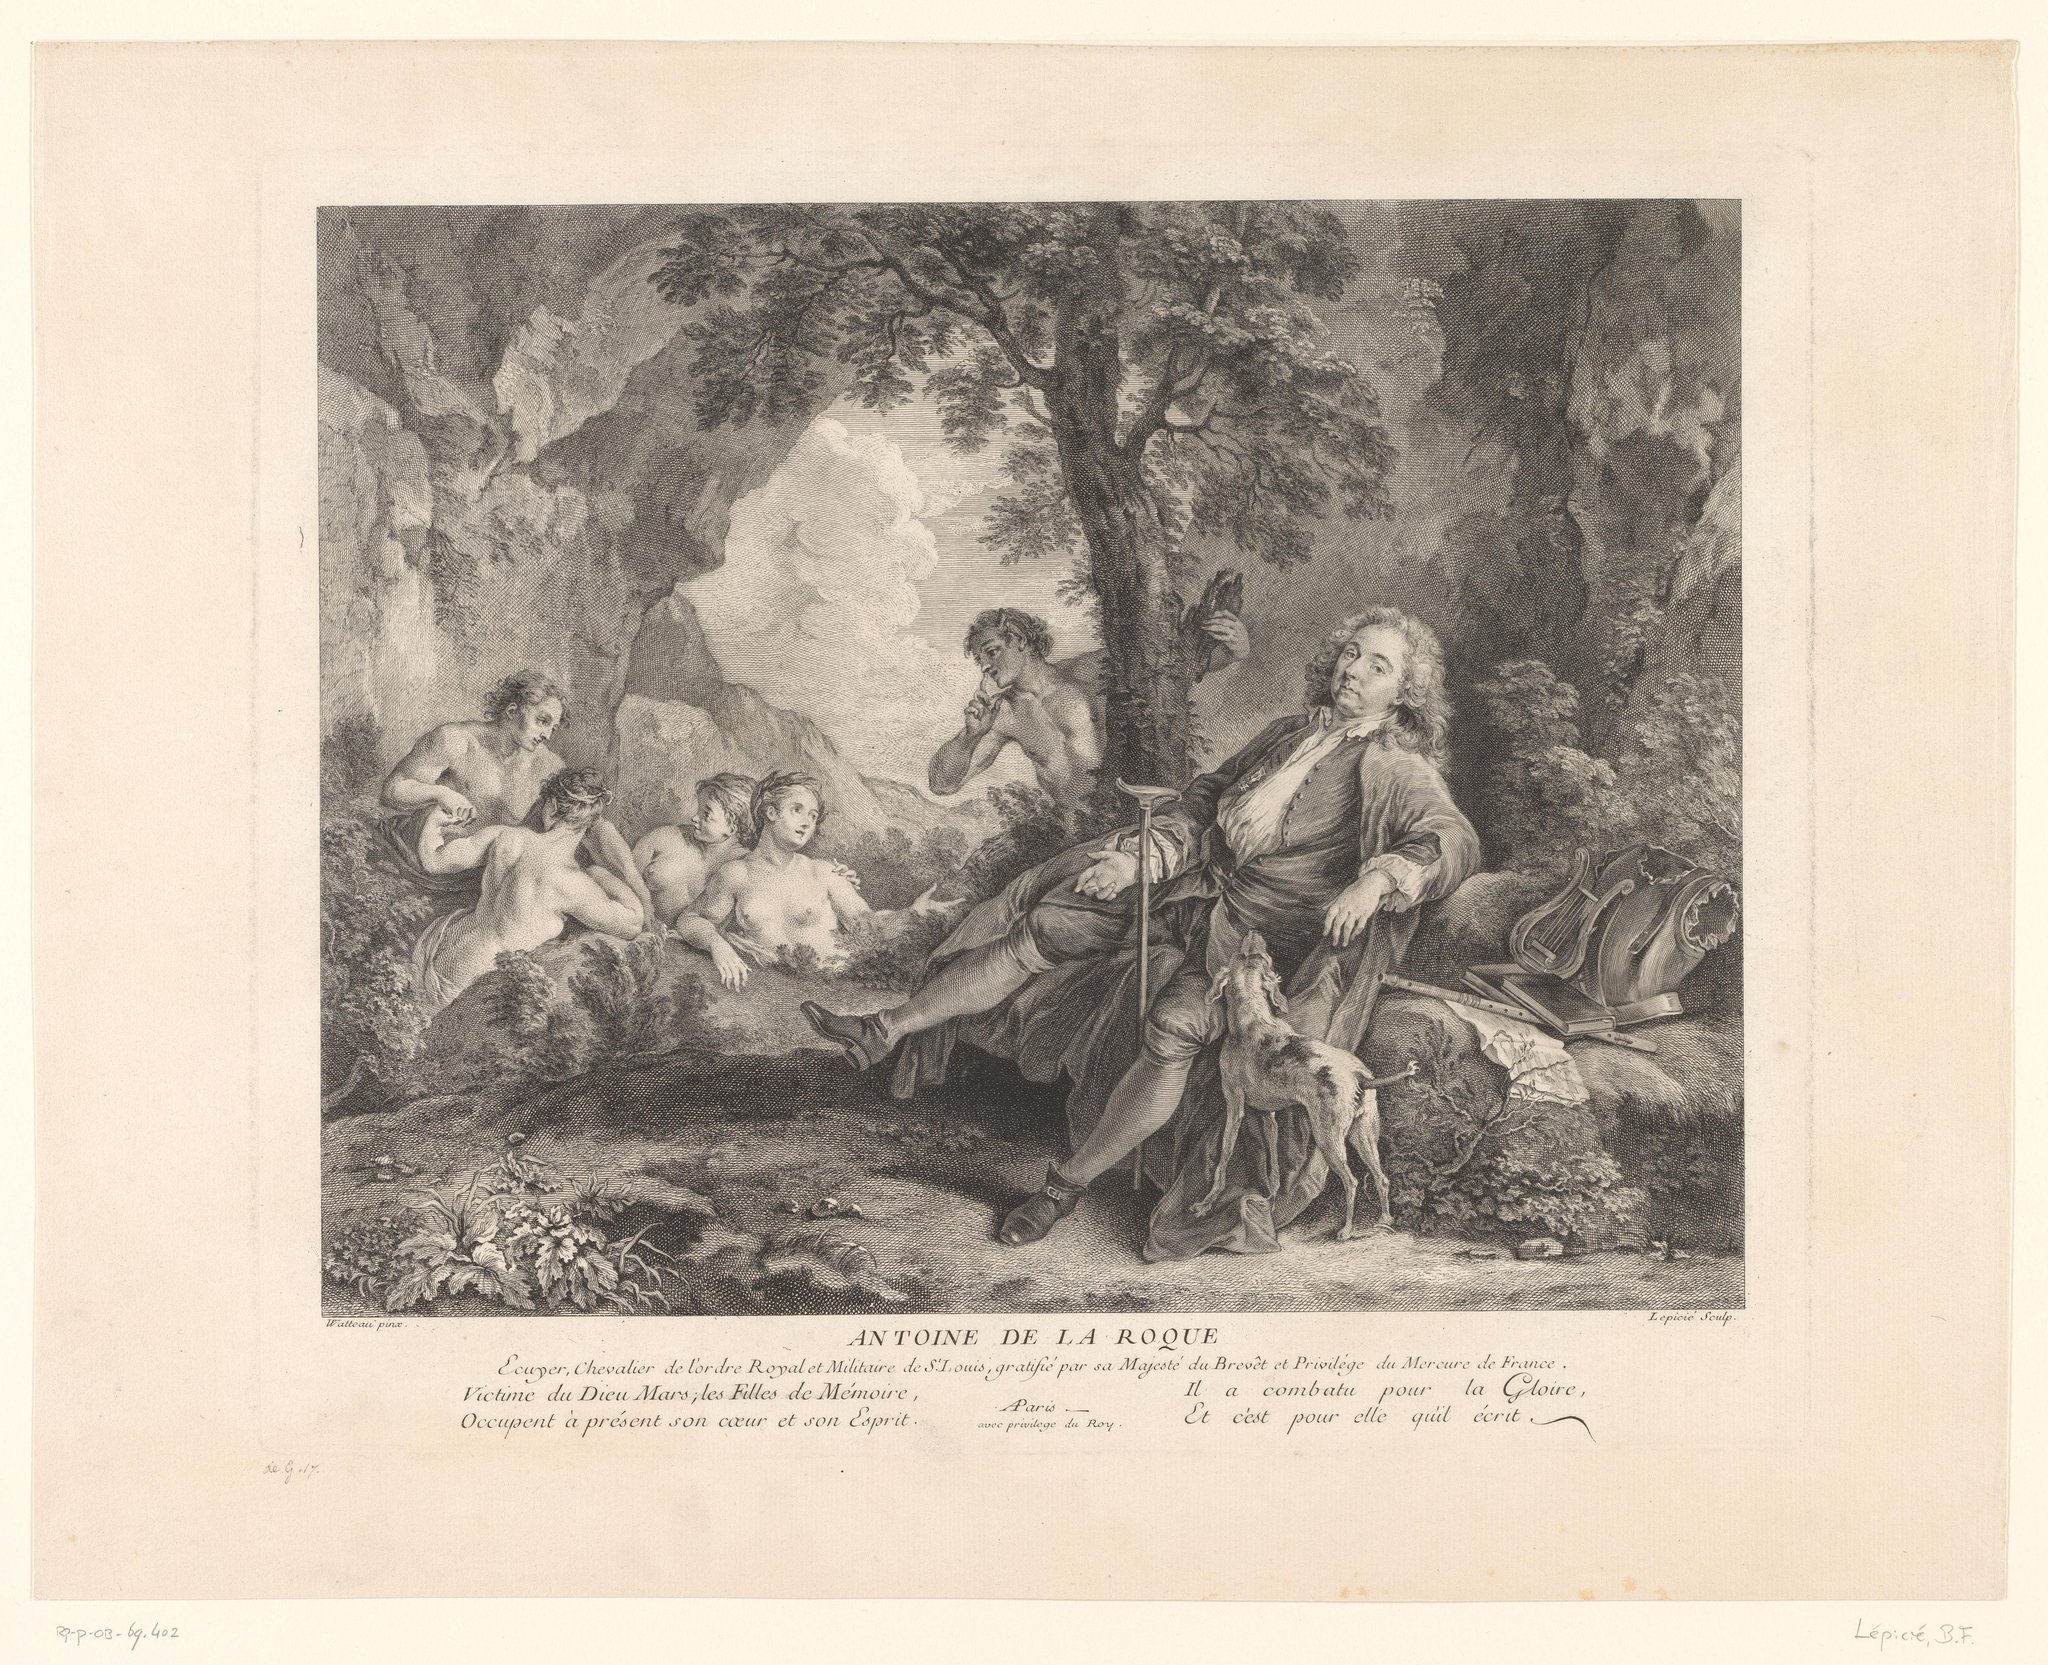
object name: print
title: L'Oeuvre d'Antoine Watteau, peintre du roy en son Academie roïale de peinture et sculpture (...)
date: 1734-1735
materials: paper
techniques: engraving, etching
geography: france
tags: marseille, paris, historical persons, the muses acting together (as group)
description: Maakt deel uit van een serie van 271 platen naar schilderijen door Watteau, verdeeld over drie delen, gecoördineerd door Jean de Jullienne en uitgegeven in Parijs in 1735. Sommige platen werden reeds tijdens Watteau's leven gemaakt.